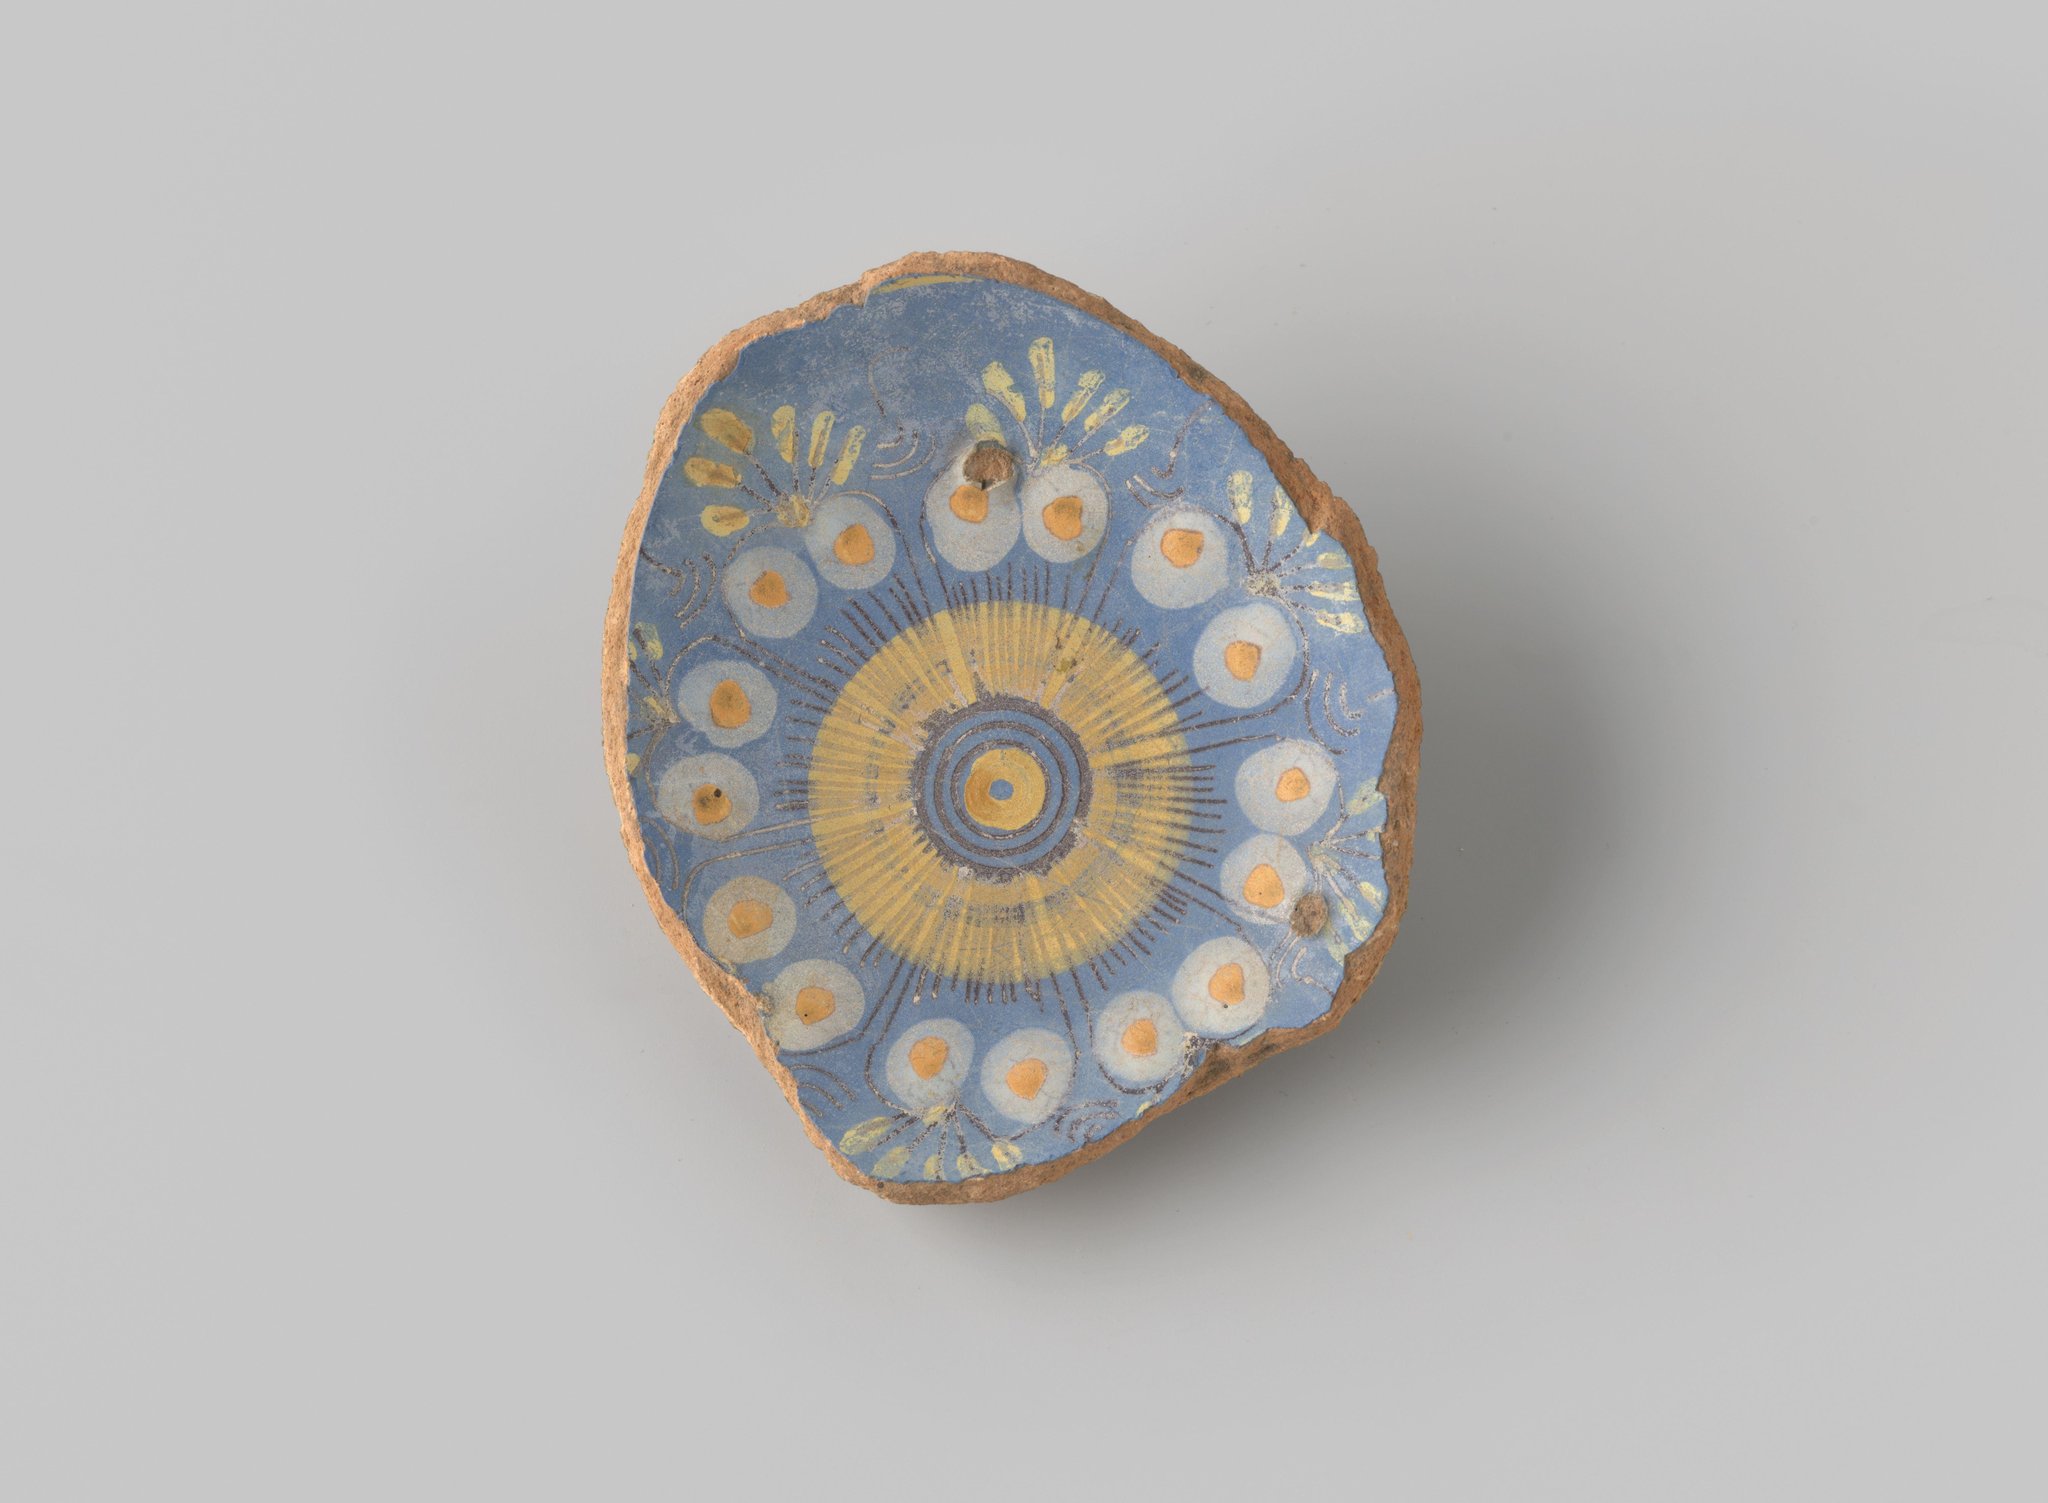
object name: sherd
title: Scherf van rossigbakkend aardewerk, met voetring, aan de voorzijde voorzien van blauw glazuur, met op het plat een schildering met gestileerde bloemvormen in bruin, blauw, groen, geel en wit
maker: Anonymous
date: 1600-1650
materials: earthenware, glaze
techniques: maiolica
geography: northern netherlands